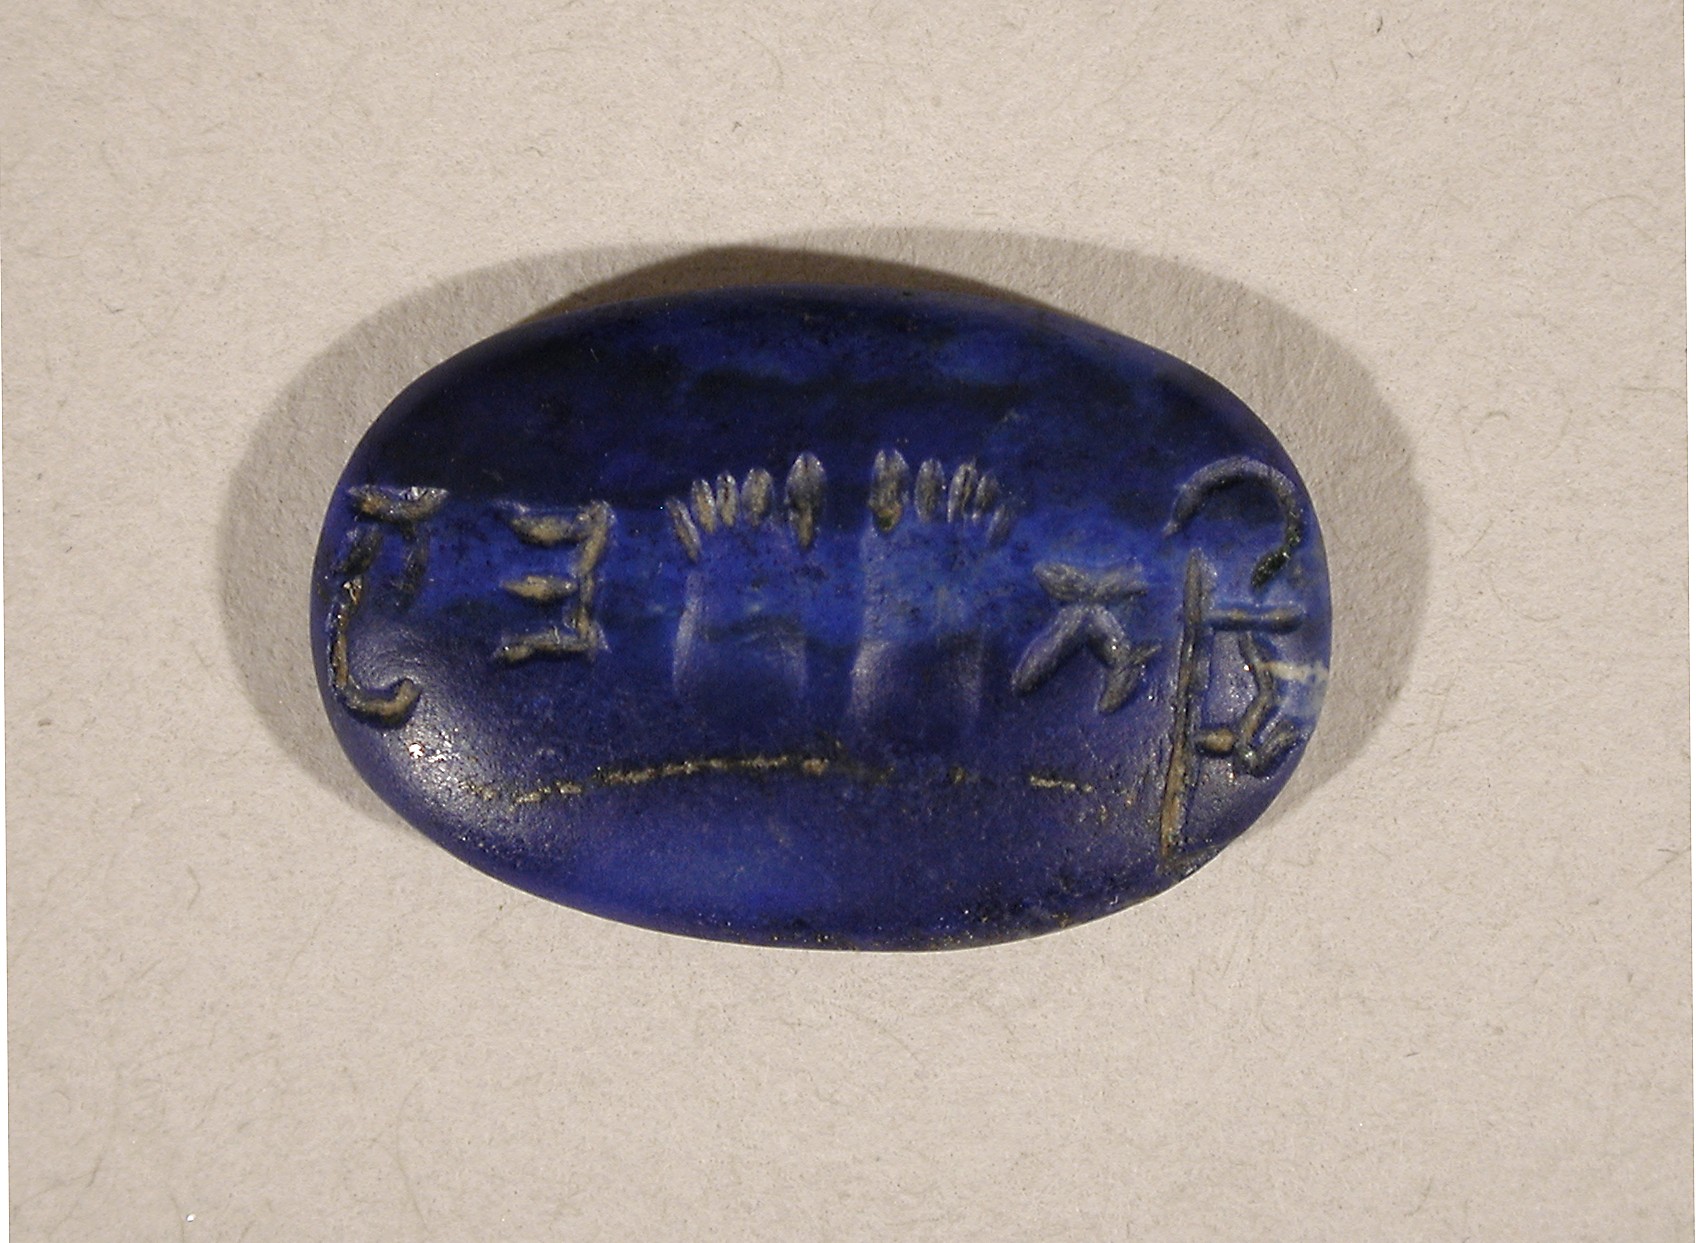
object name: seal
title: Intaglio Seal with Footprints of the Buddha (Buddhapada)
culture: gandhara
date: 301-400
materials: lapis lazuli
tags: gandharan